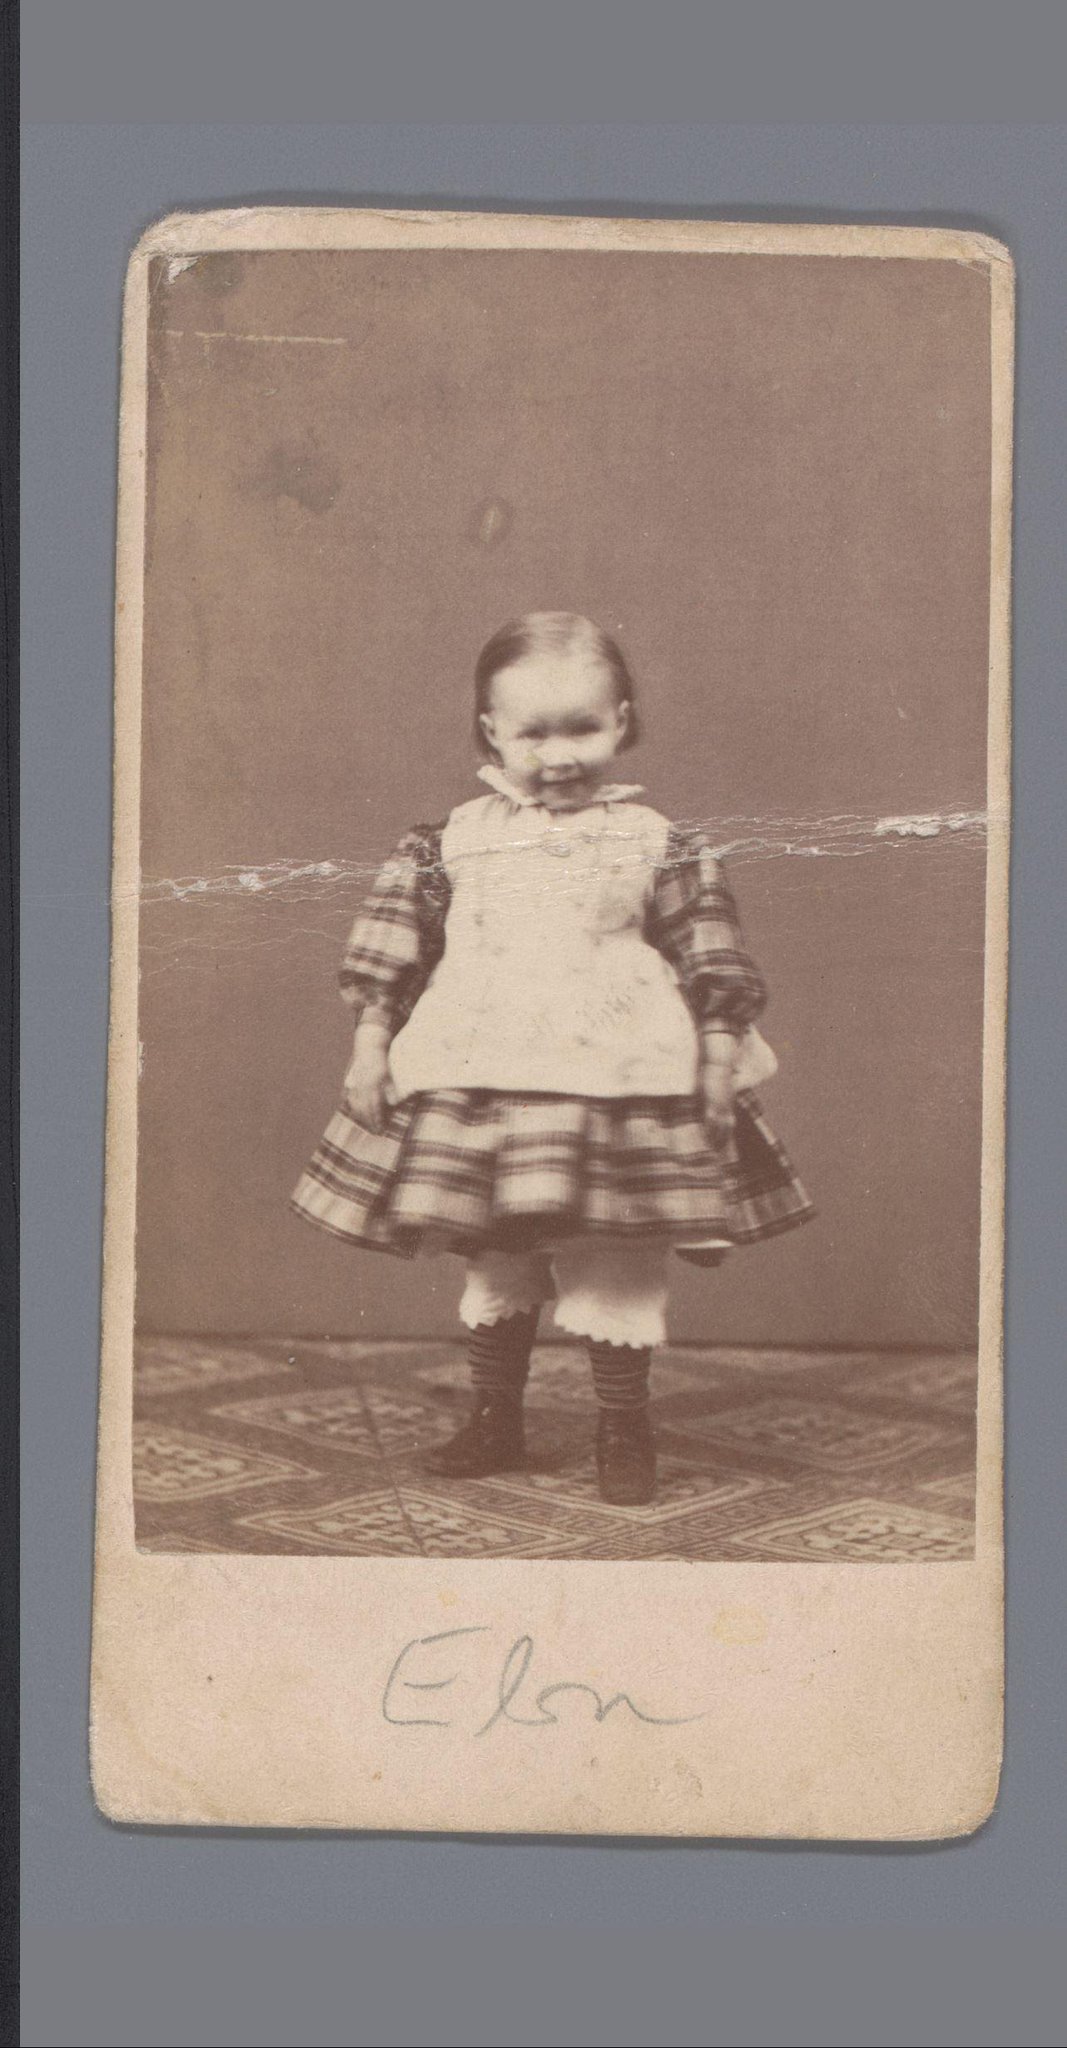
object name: photograph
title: Portret van een onbekend meisje, aangeduid als Elsa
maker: lindman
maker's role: fotograaf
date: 1863-1866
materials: cardboard, paper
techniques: albumen print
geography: stockholm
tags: historical persons, girl (child between toddler and youth)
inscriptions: inscription: ‘Elsa’, inscription: ‘FOTOGRAFISK ATELIER/ LINDMAN/ Wahrendorffsgatan No. 8/ vid. Berzelii park.’